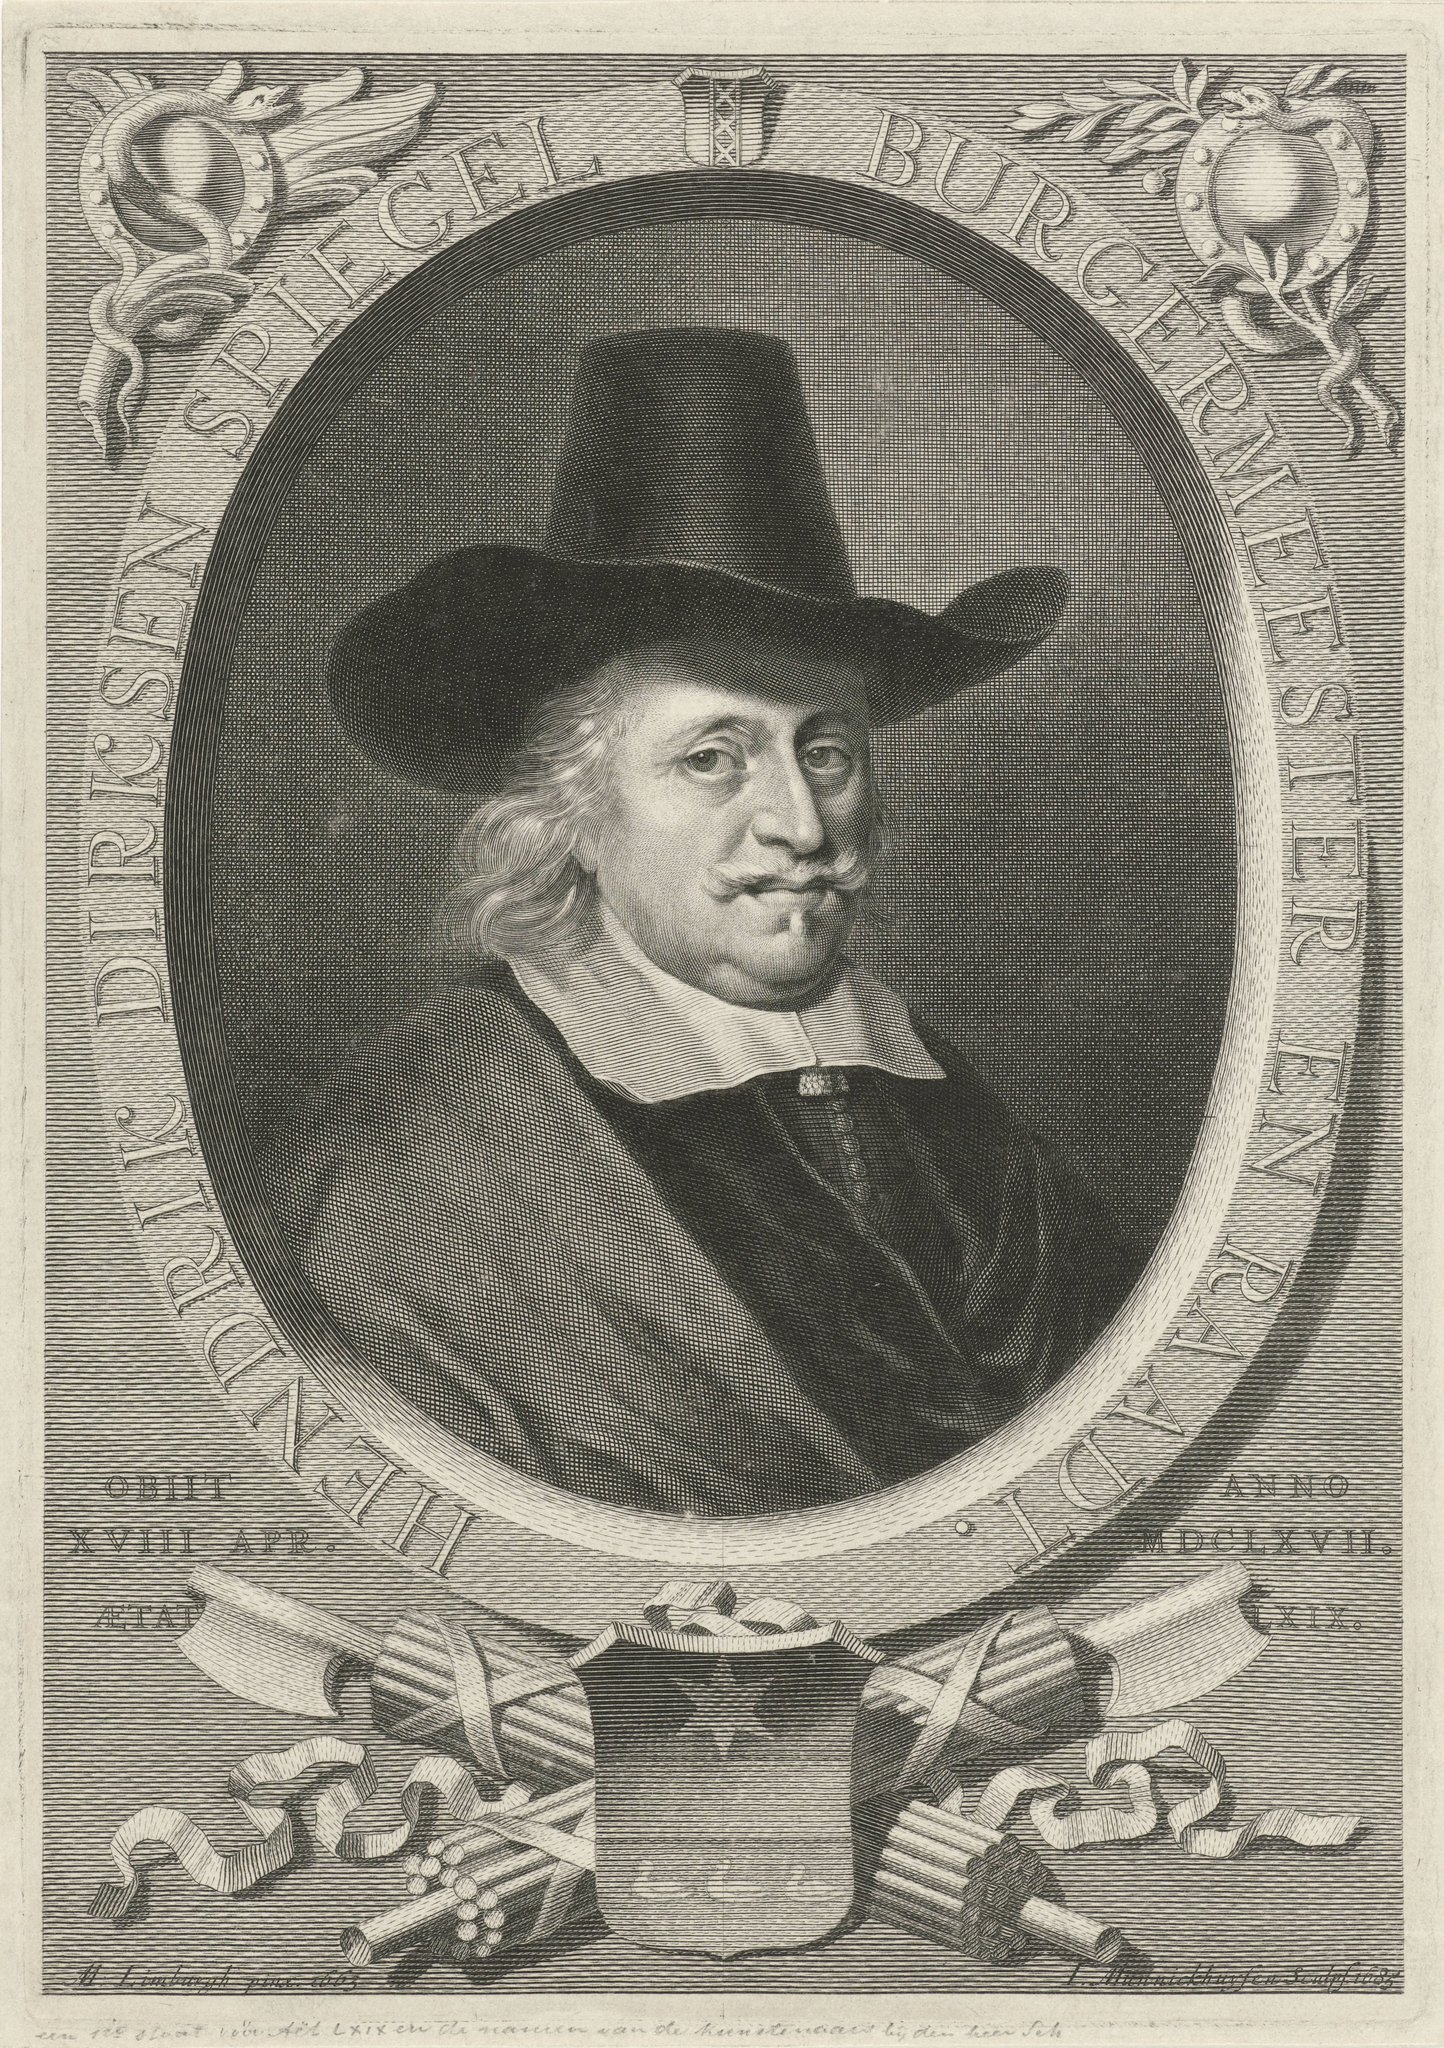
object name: print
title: Portret van Hendrick Dircksz. Spiegel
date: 1685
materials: paper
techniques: engraving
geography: netherlands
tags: amsterdam, mayor, hendrick dircksz. spiegel, head-gear: hat (+ men's clothes)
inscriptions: collector's mark: Lugt 240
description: Portret van Hendrick Dircksz. Spiegel, burgemeester van Amsterdam in 1655, 1659, 1663 en 1665. Onder het portret twee fasces en zijn wapenschild.